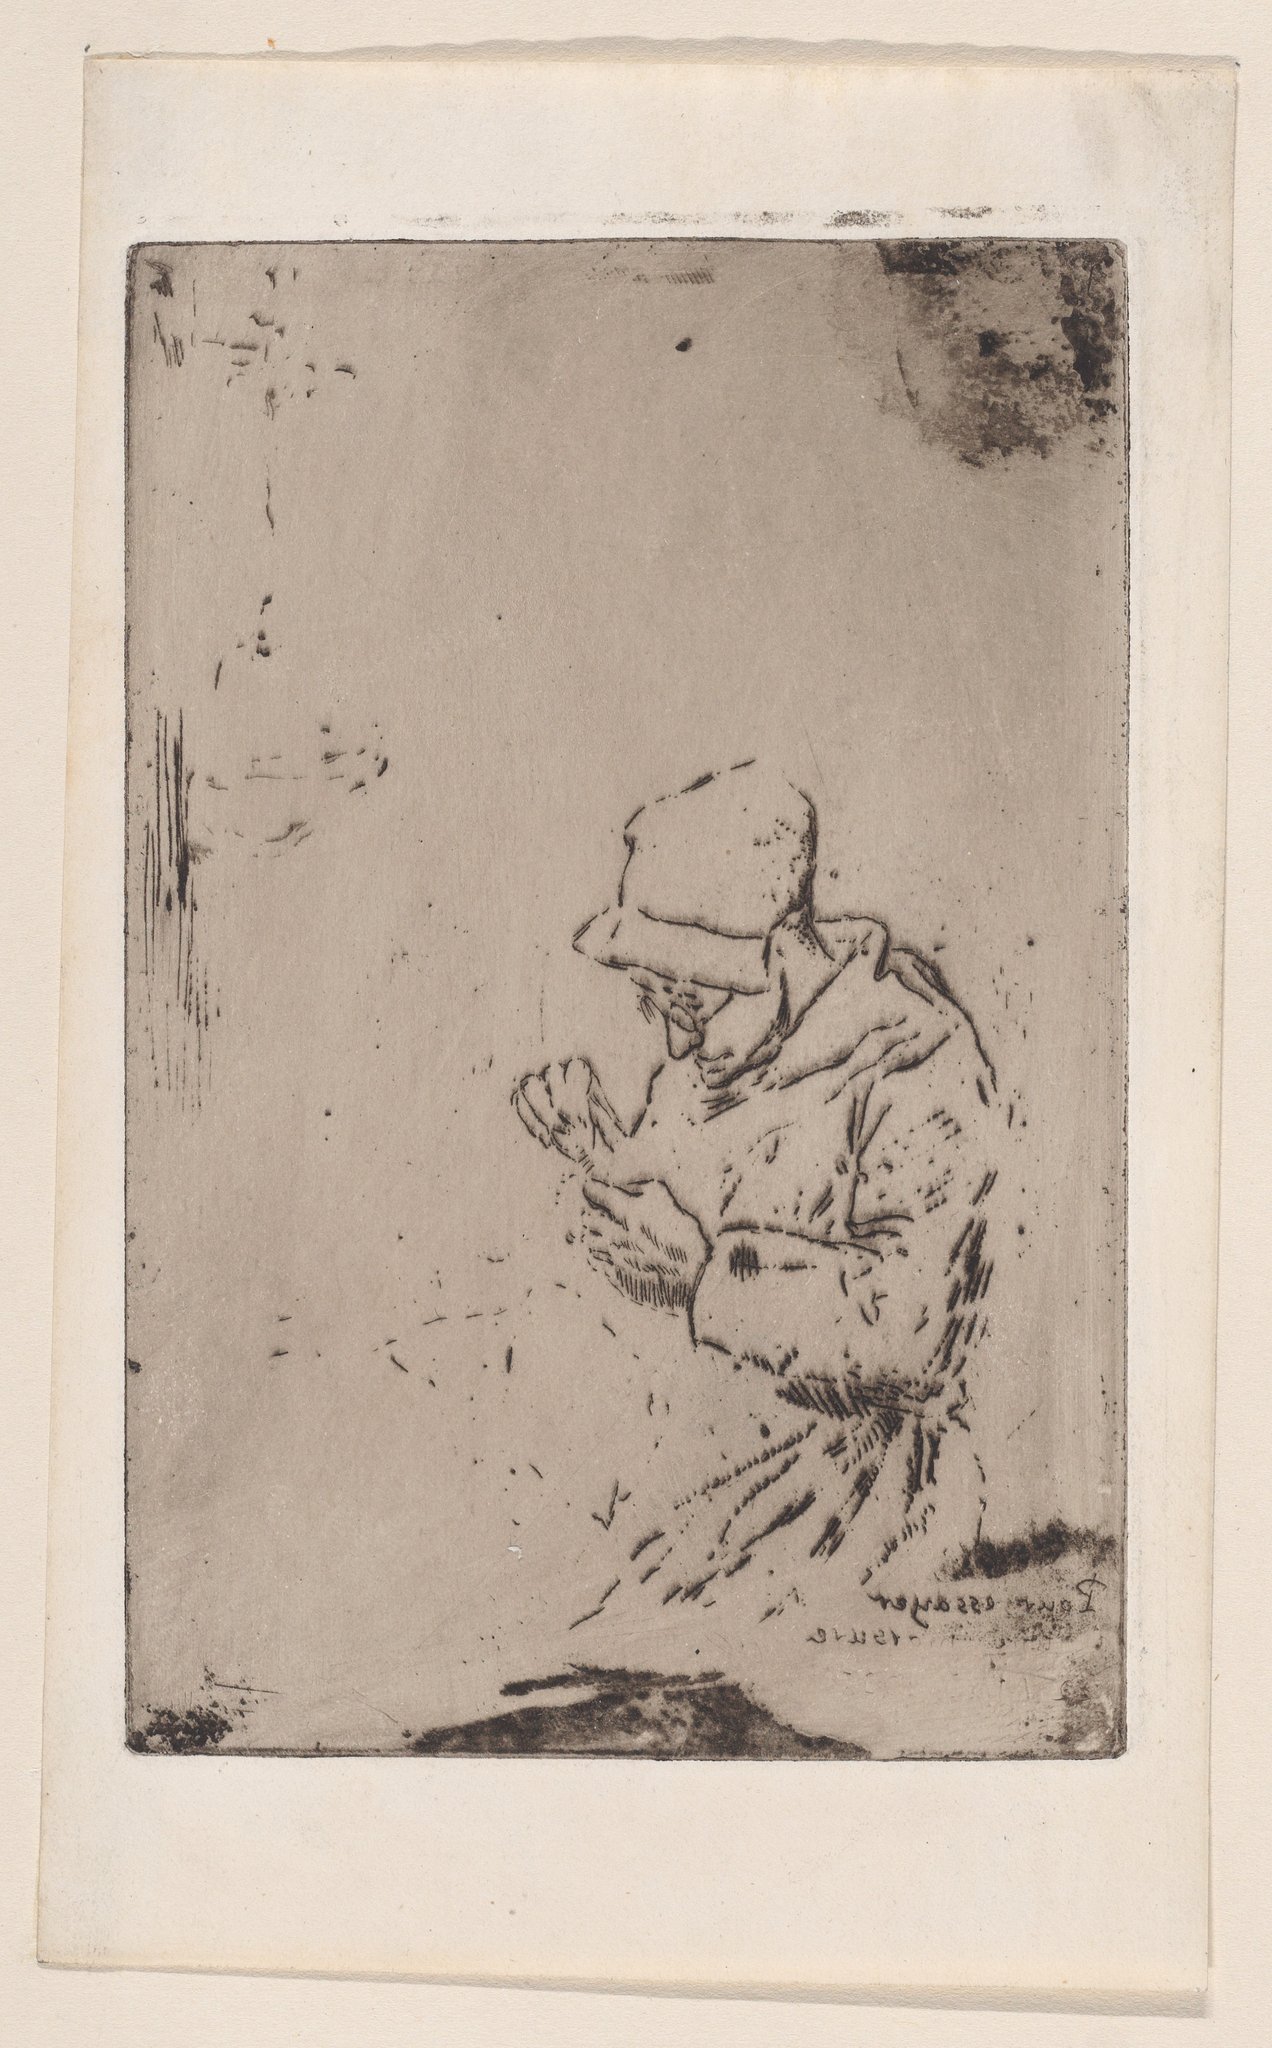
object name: print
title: The Maid Sewing (Bonne Femme Cousant)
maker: félix-hilaire buhot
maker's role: artist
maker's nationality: french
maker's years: 1847-1898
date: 1860-1898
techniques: aquatint, etching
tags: women,sewing